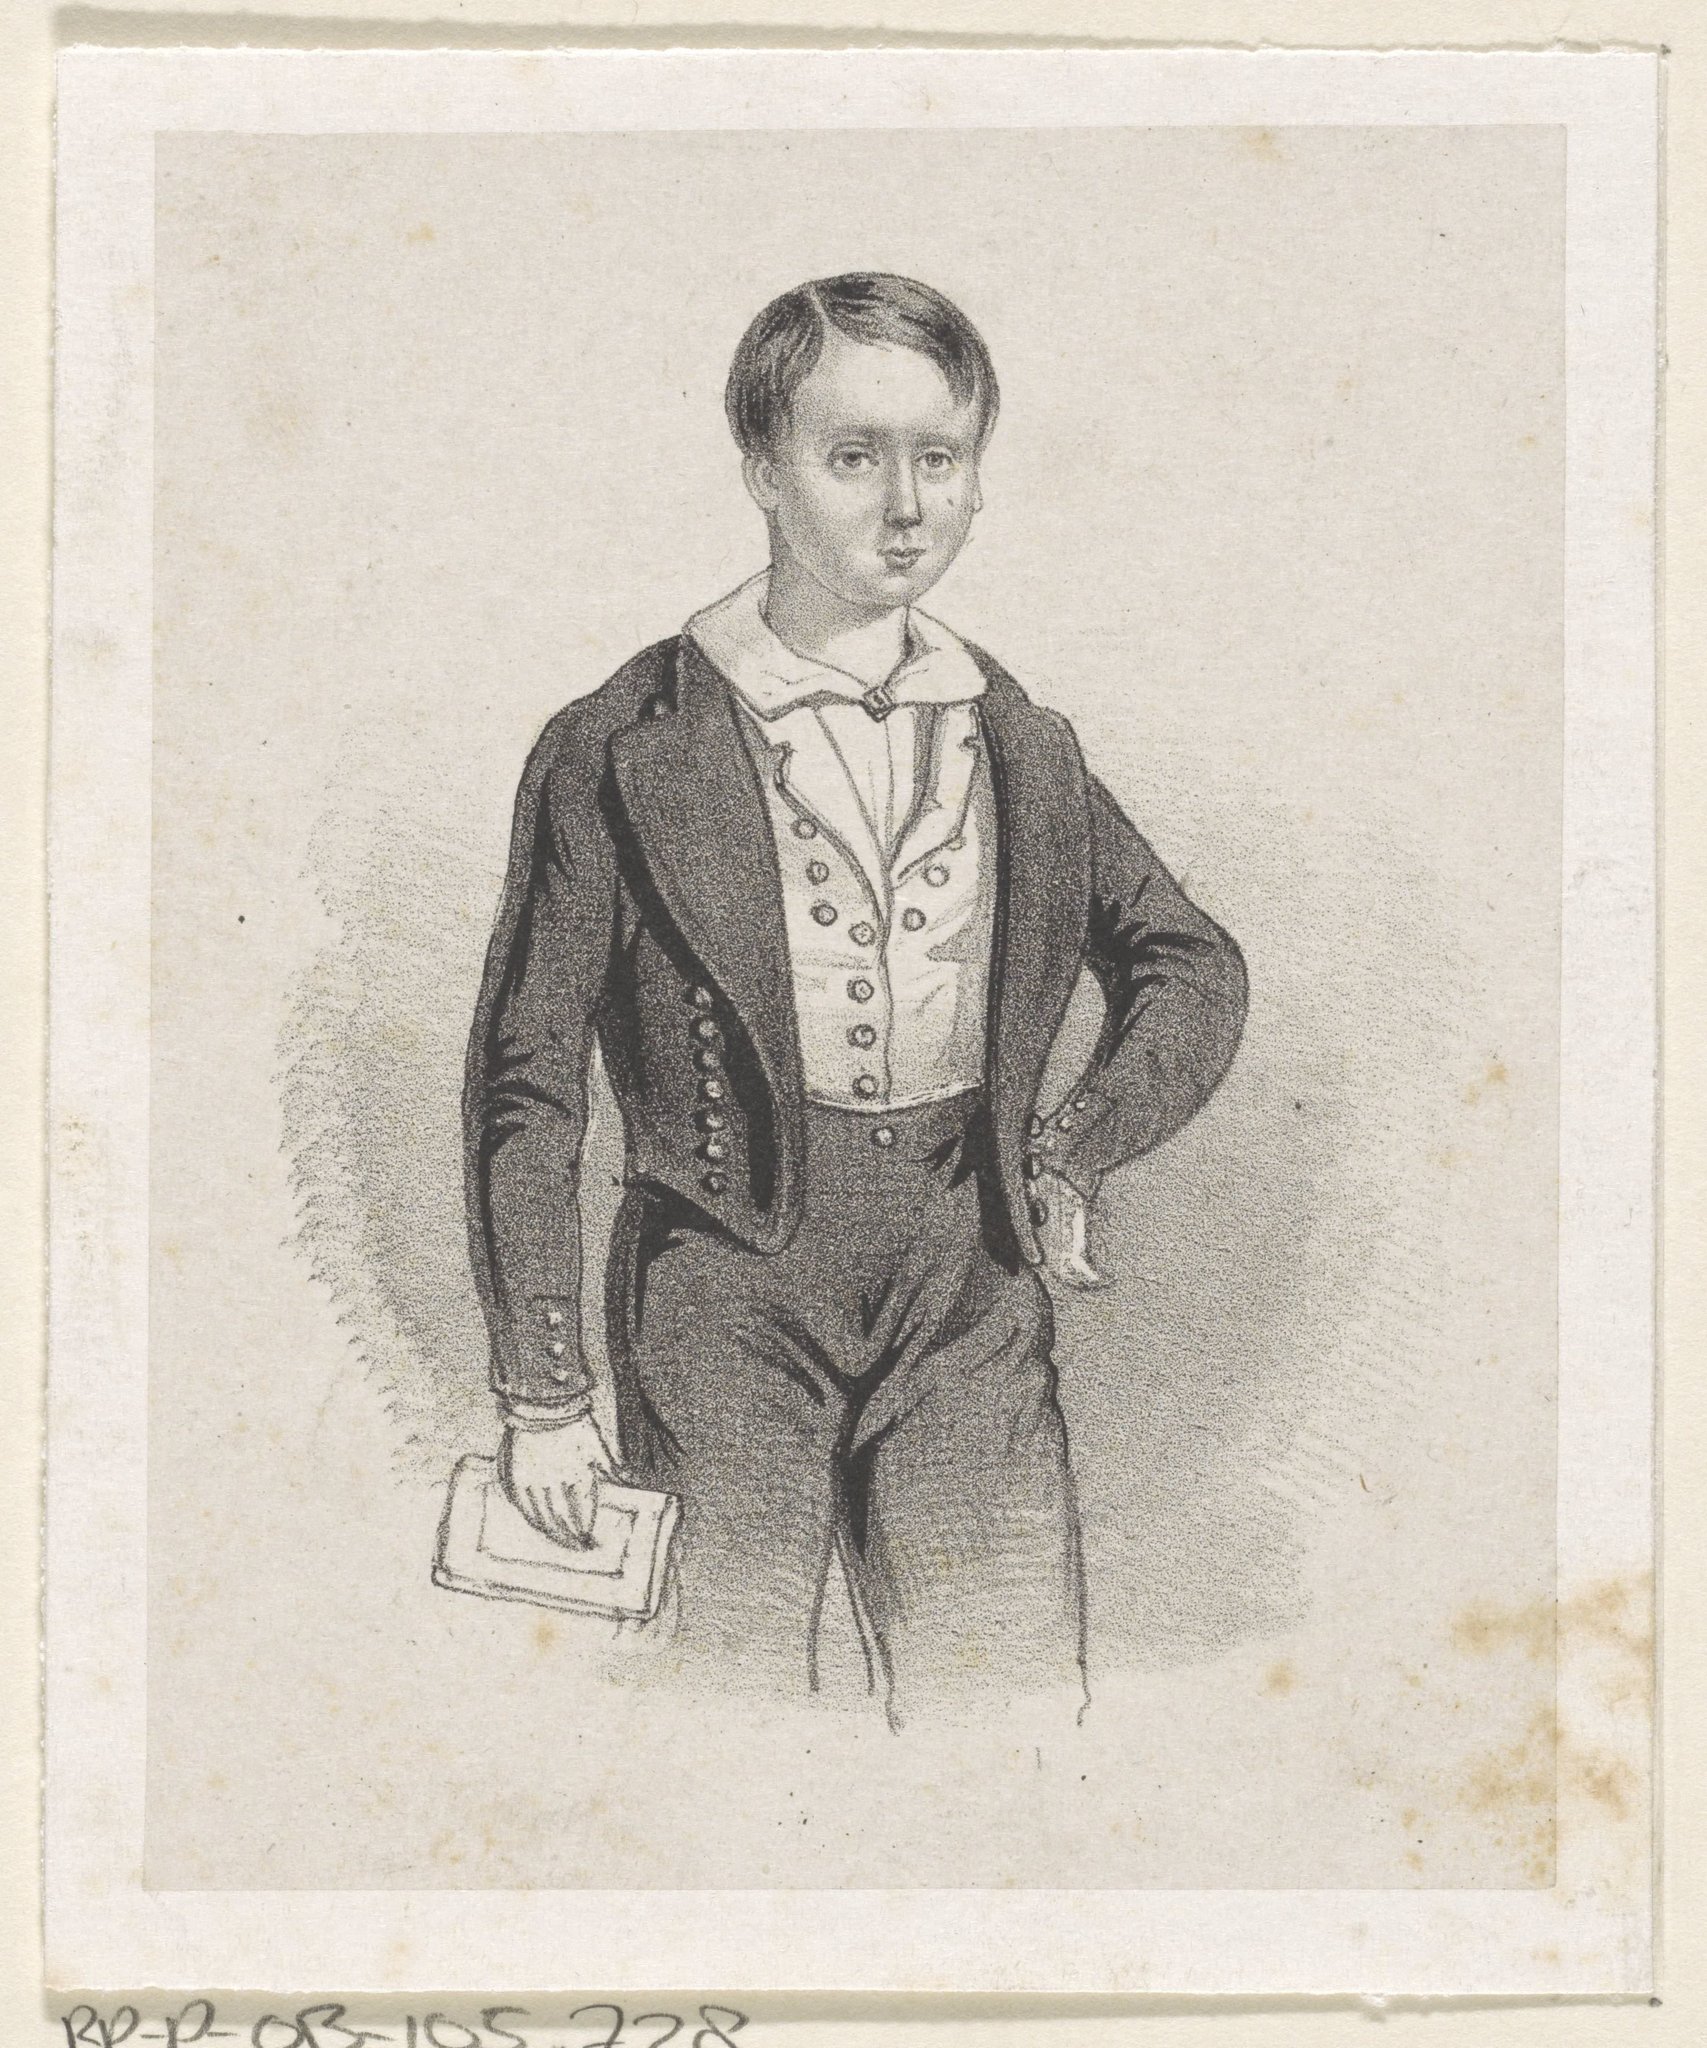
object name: print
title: Portret van Willem, prins der Nederlanden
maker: Anonymous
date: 1845-1899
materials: paper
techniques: lithograph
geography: netherlands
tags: the hague, paris, willem (prins der nederlanden)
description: De hier vermelde titel verwijst naar de hoogst verkregen titel van de geportretteerde, niet per se naar de titel die de geportretteerde op deze voorstelling draagt.